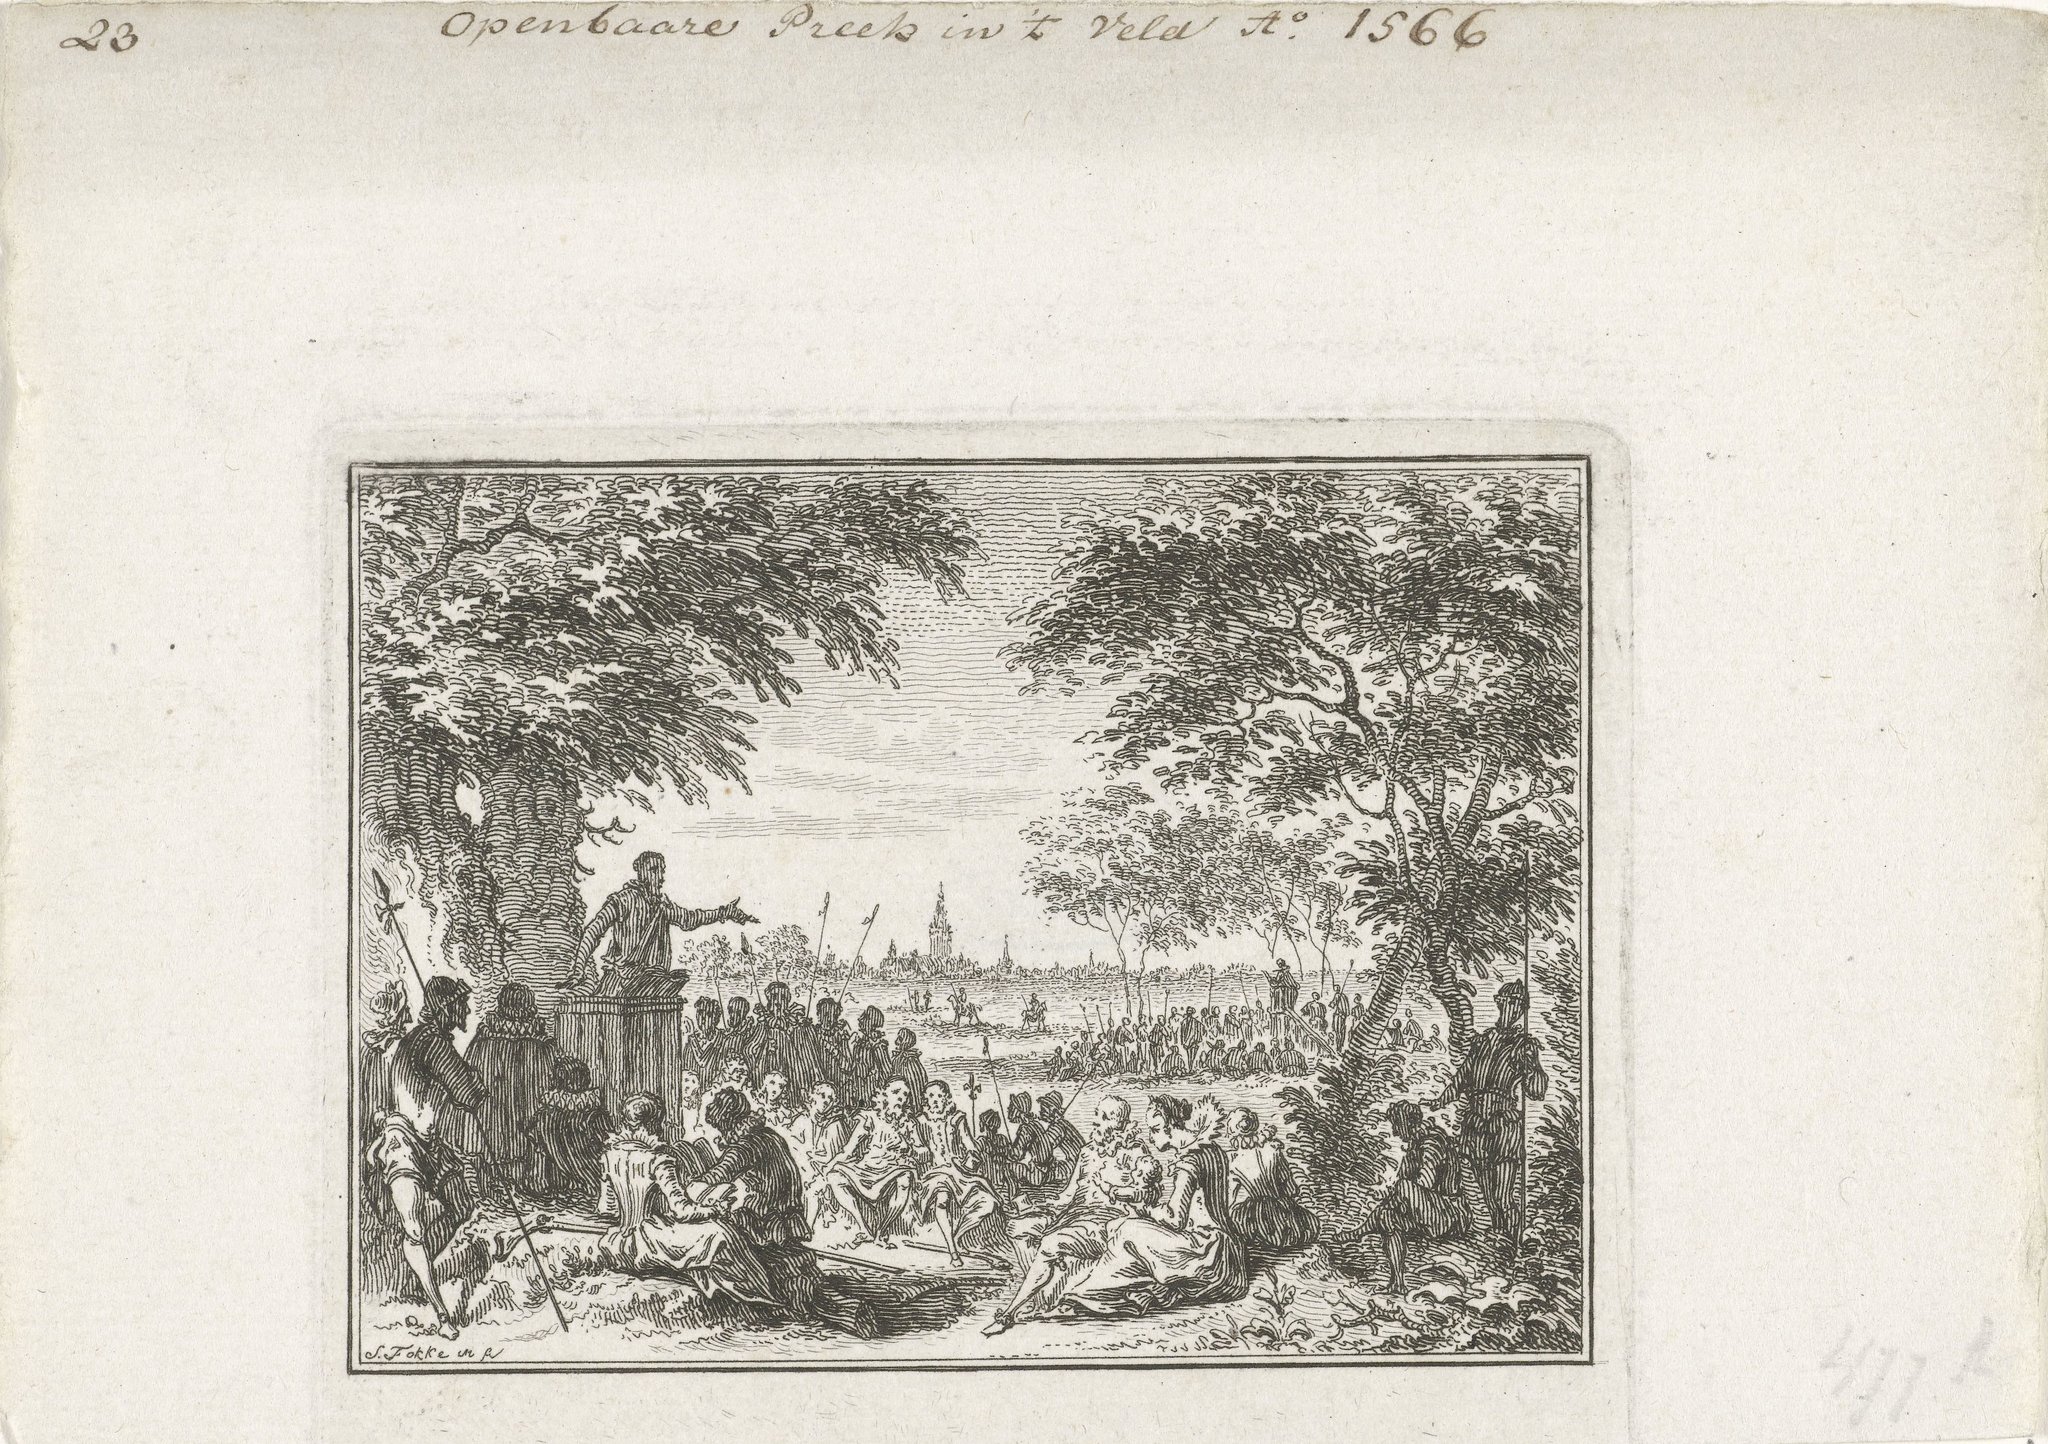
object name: history print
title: Openbare preek in het veld, 1566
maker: simon fokke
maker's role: draughtsman, print maker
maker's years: 1712-1784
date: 1782-1784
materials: paper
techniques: etching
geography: northern netherlands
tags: sermon ~ protestant service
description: Openbare preek in het veld, 1566. Hagenpreek buiten de stad: een predikant sprekend onder een boom, toehoorders zittend op de grond.